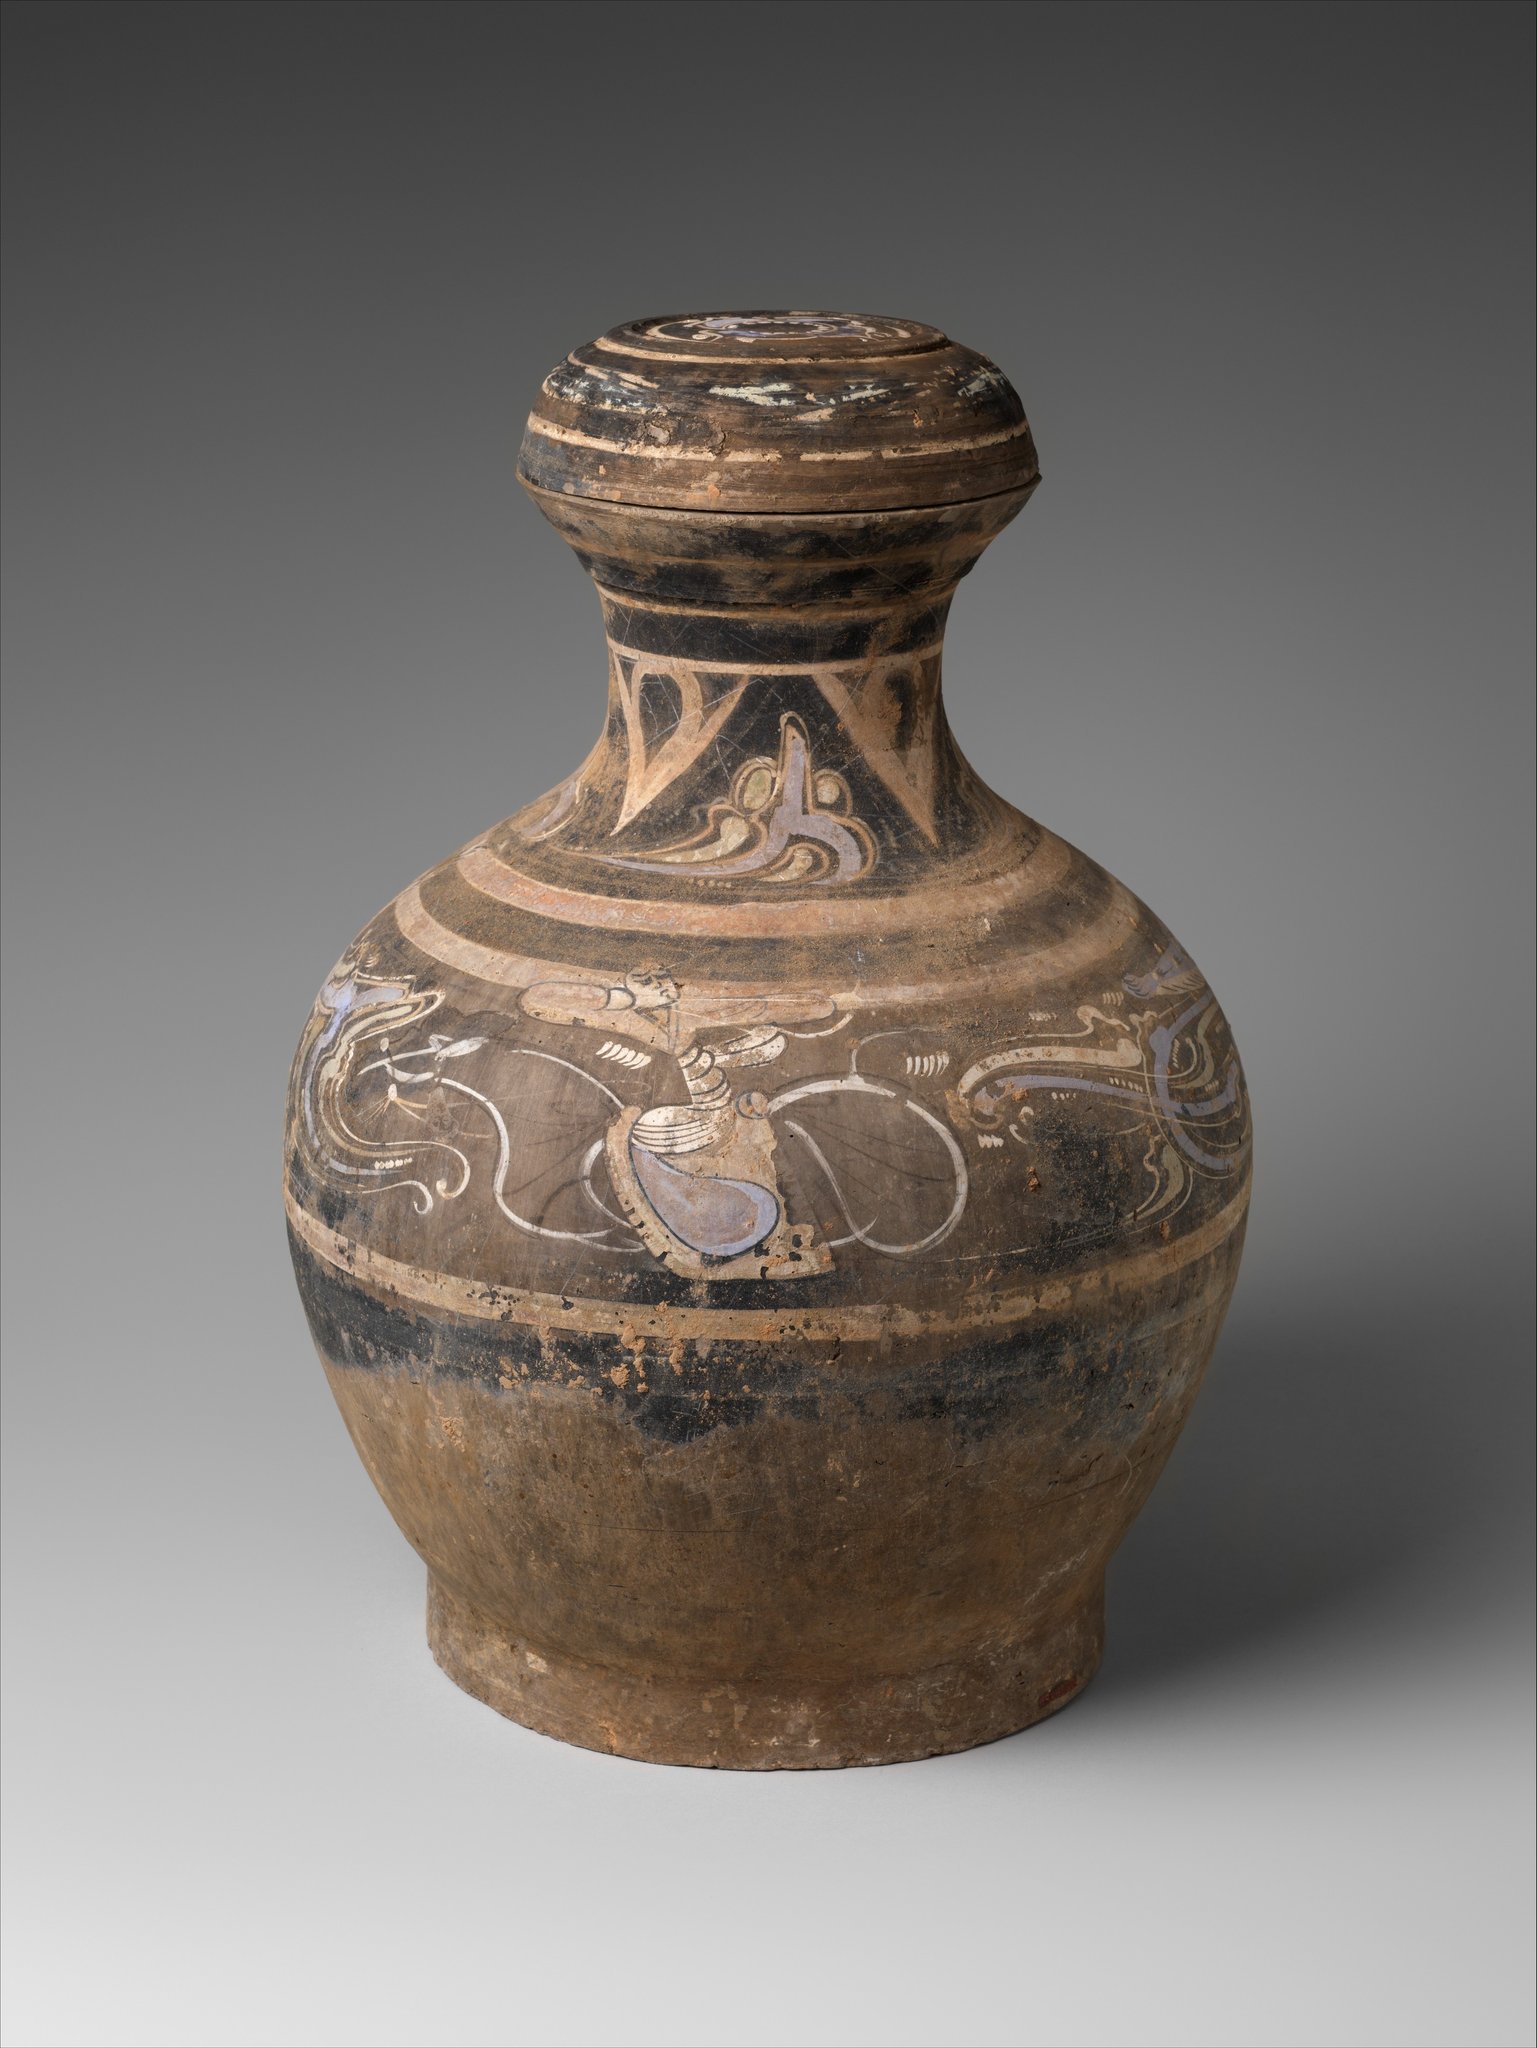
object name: covered jar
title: Covered Jar (Hu)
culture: chinese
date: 200-1 BCE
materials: earthenware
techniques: painting